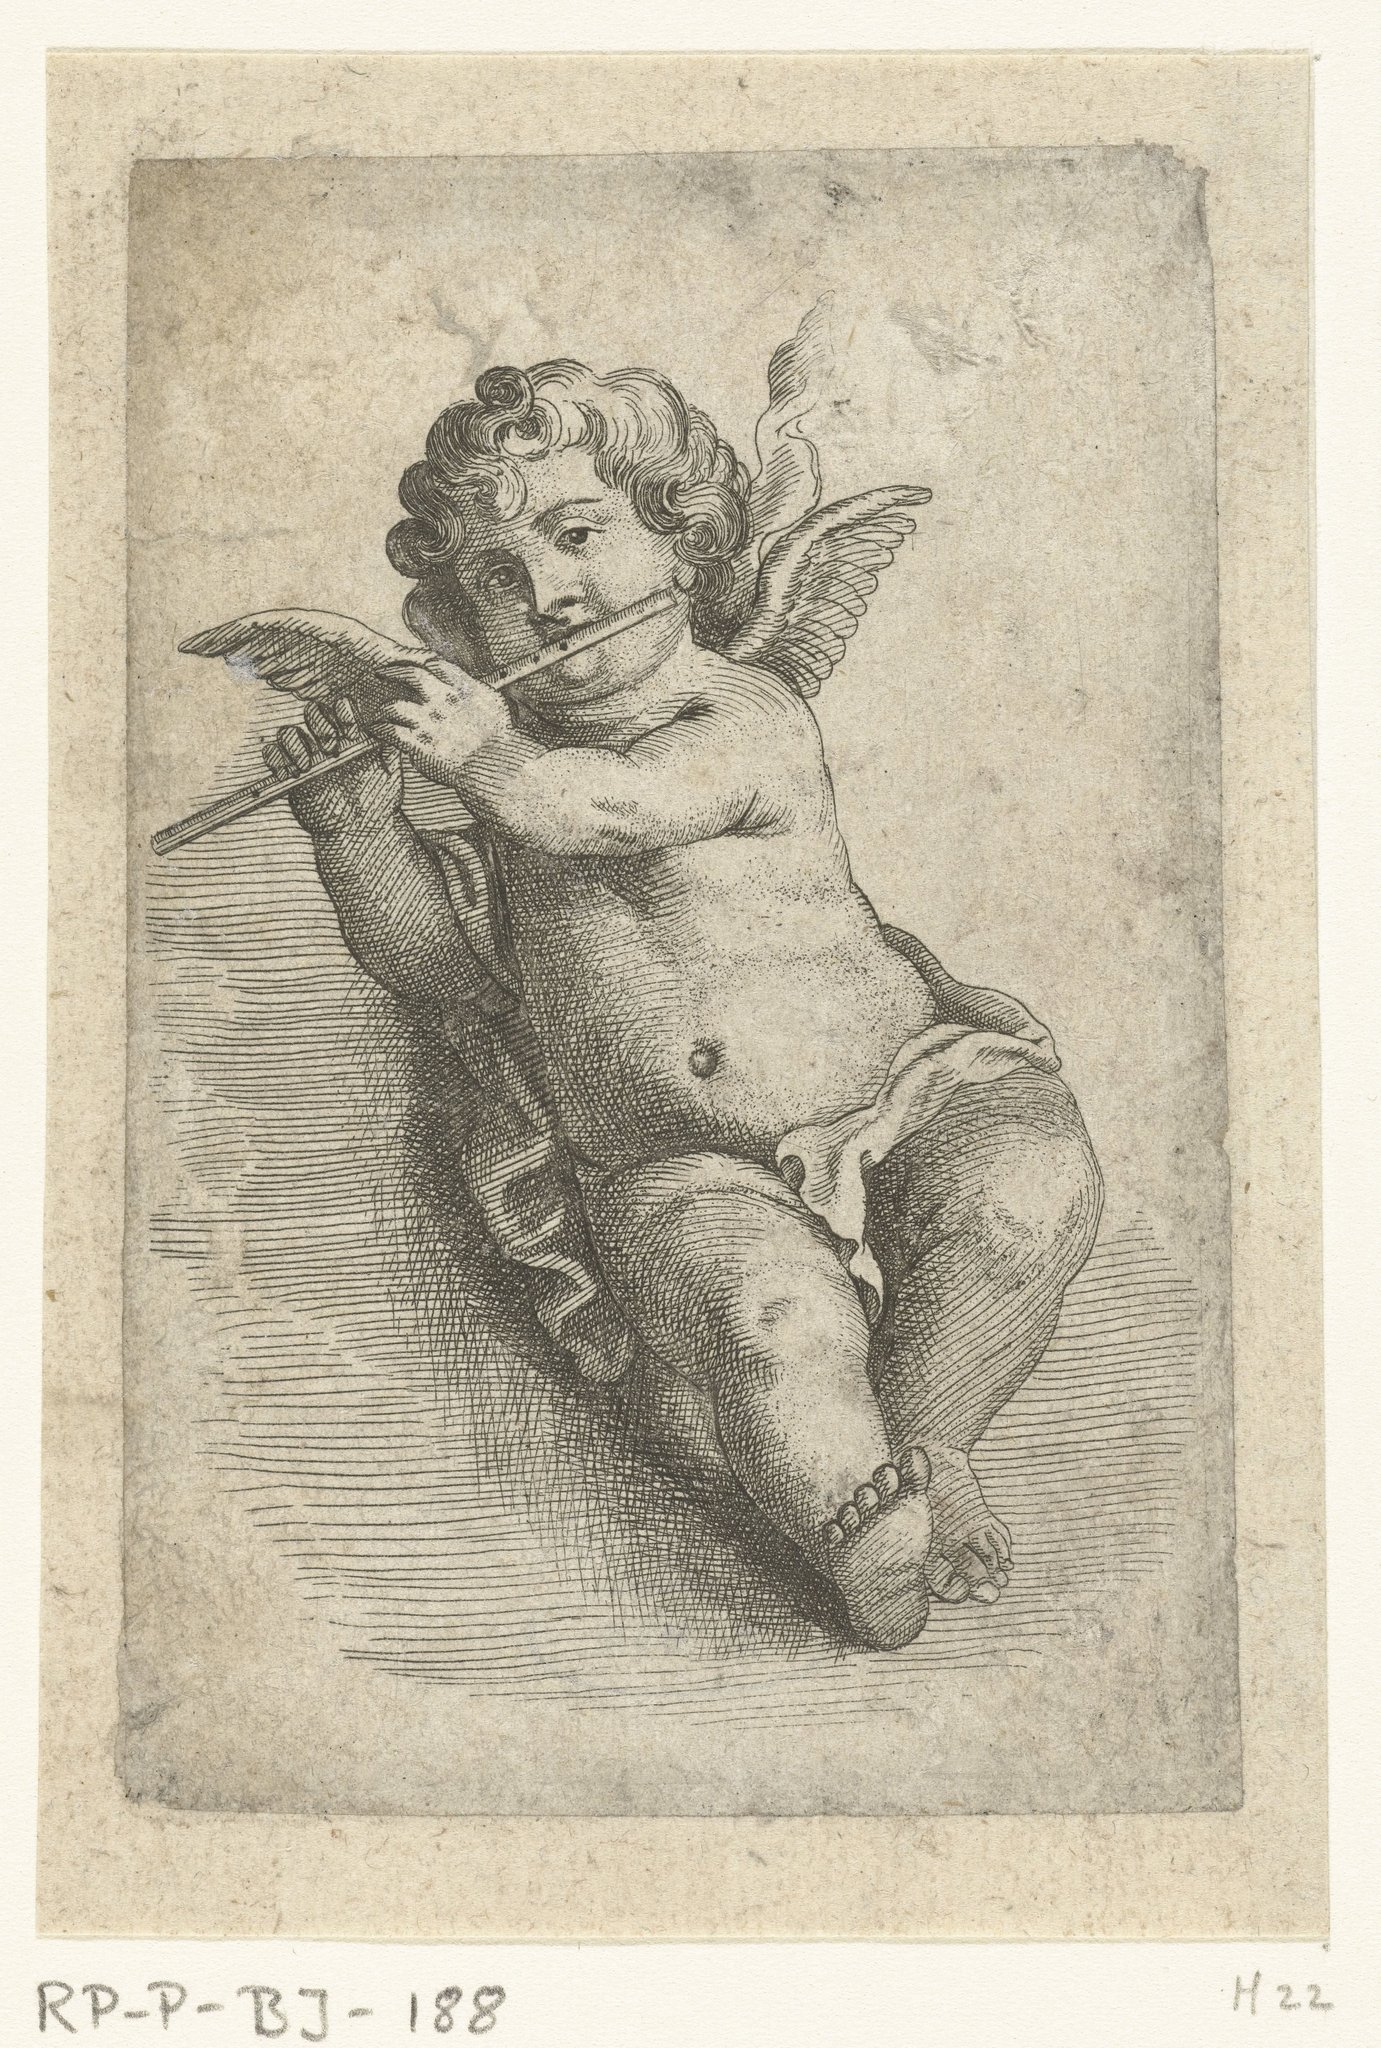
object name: print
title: Kinderen en engelen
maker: pieter van avont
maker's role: print maker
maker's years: 1600-1652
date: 1630-1652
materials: paper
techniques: engraving, etching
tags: angels singing, making music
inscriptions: collector's mark: Lugt 2228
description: Fluit spelend engeltje. Prent uit een serie van 24 prenten met engelen of kinderen.